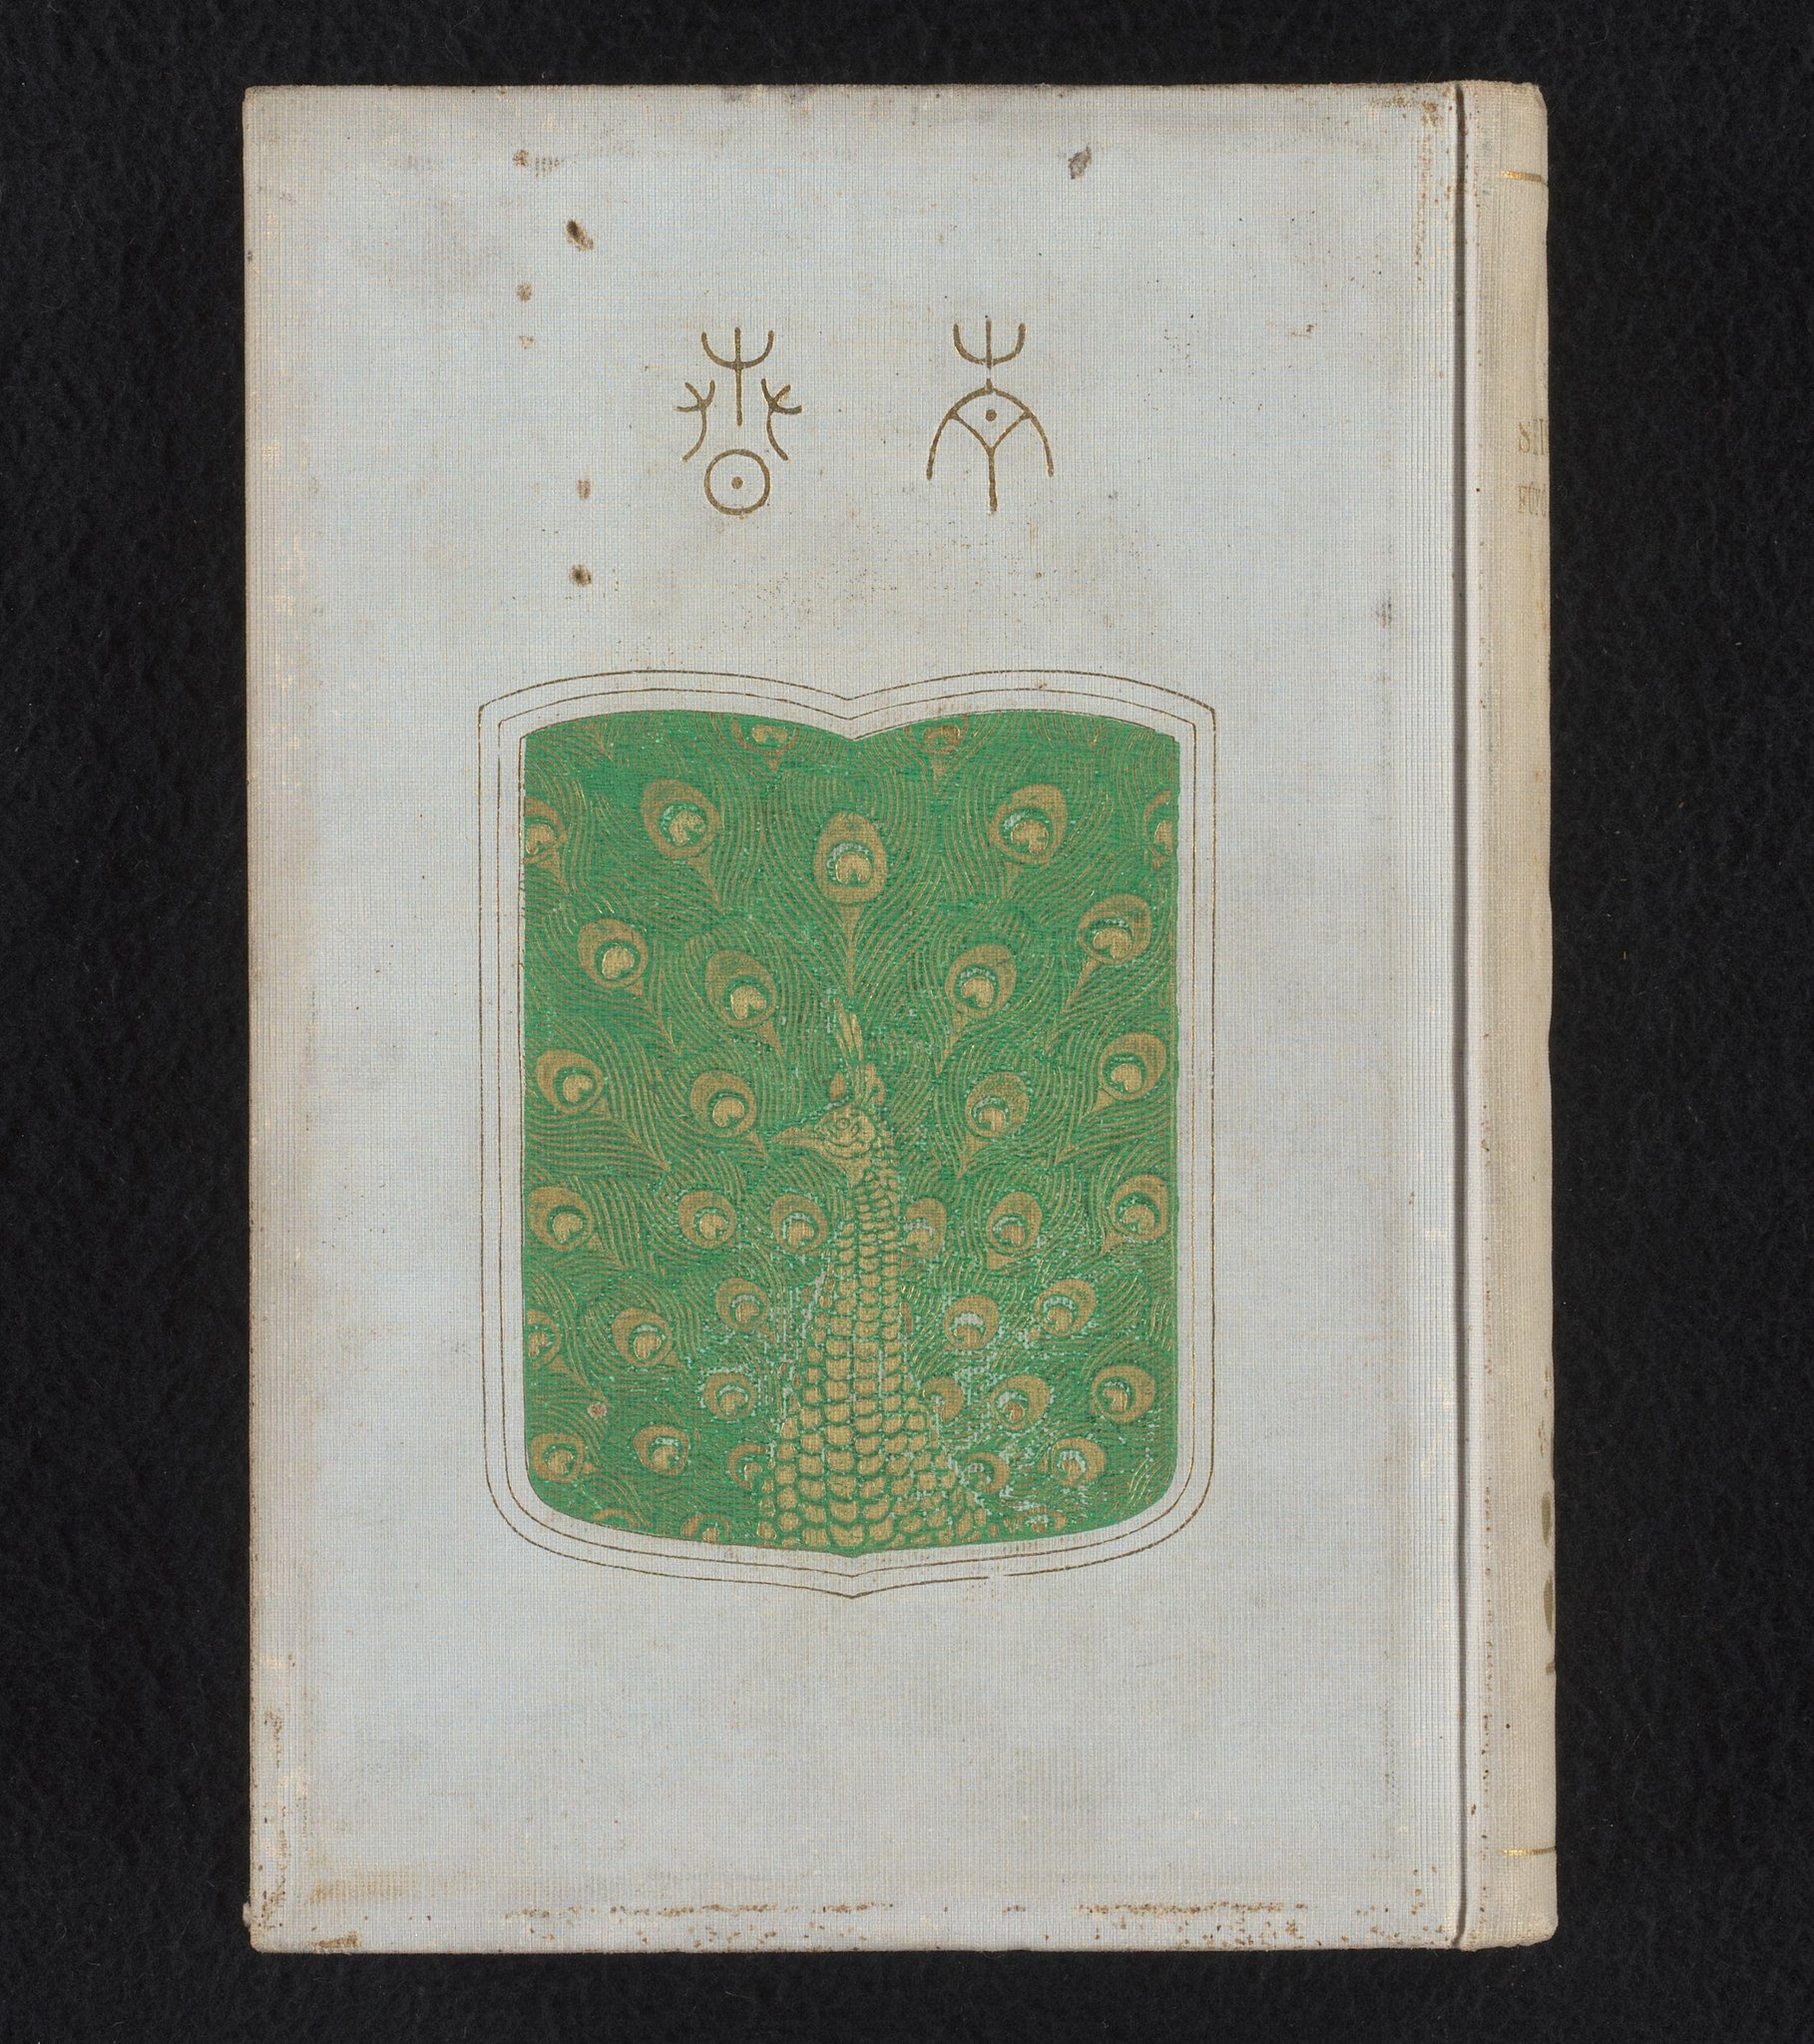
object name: book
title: Natsu no maki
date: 1906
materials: paper, textile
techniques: woodcut, letterpress printing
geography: japan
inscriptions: date